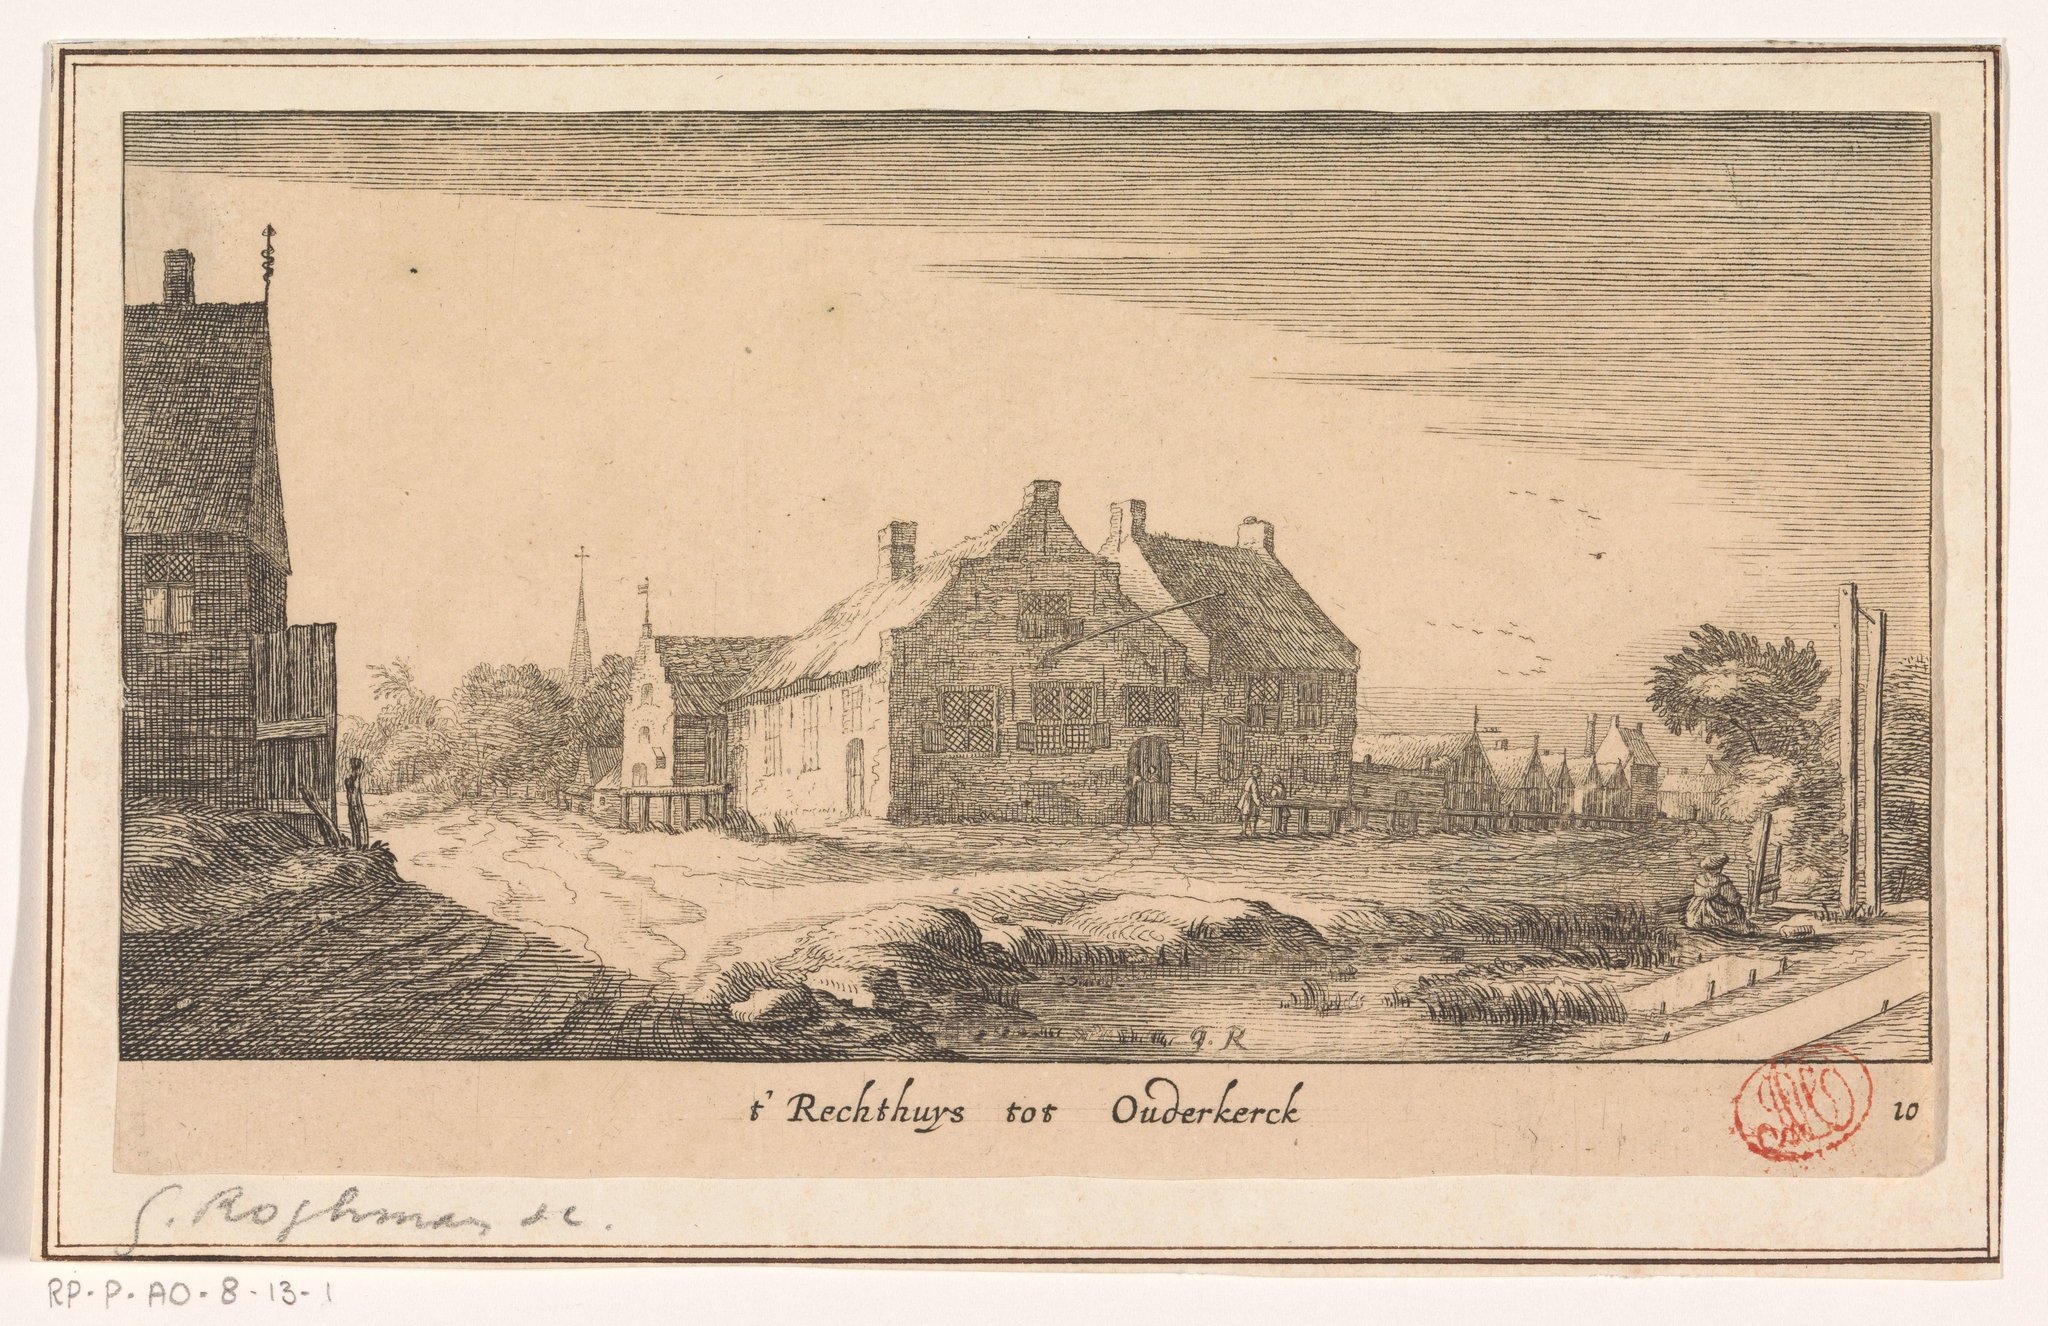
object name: print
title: t' Rechthuys tot Ouderkerck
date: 1637-1652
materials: paper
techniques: engraving, etching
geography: amsterdam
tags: violent death by hanging, lower house, parliament, chamber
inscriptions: collector's mark: Lugt 195, collector's mark: Lugt 2233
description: Gezicht op het Rechthuis te Ouderkerk aan de Amstel, gelegen op de hoek van de Dorpsstraat (rechts) en het Kerkpad (links). Rechts van de Dorpsstraat het gerecht met de galg. De prent is deel van een serie landschappen met dorpen rondom Amsterdam. Rechtsonder genummerd: 10.